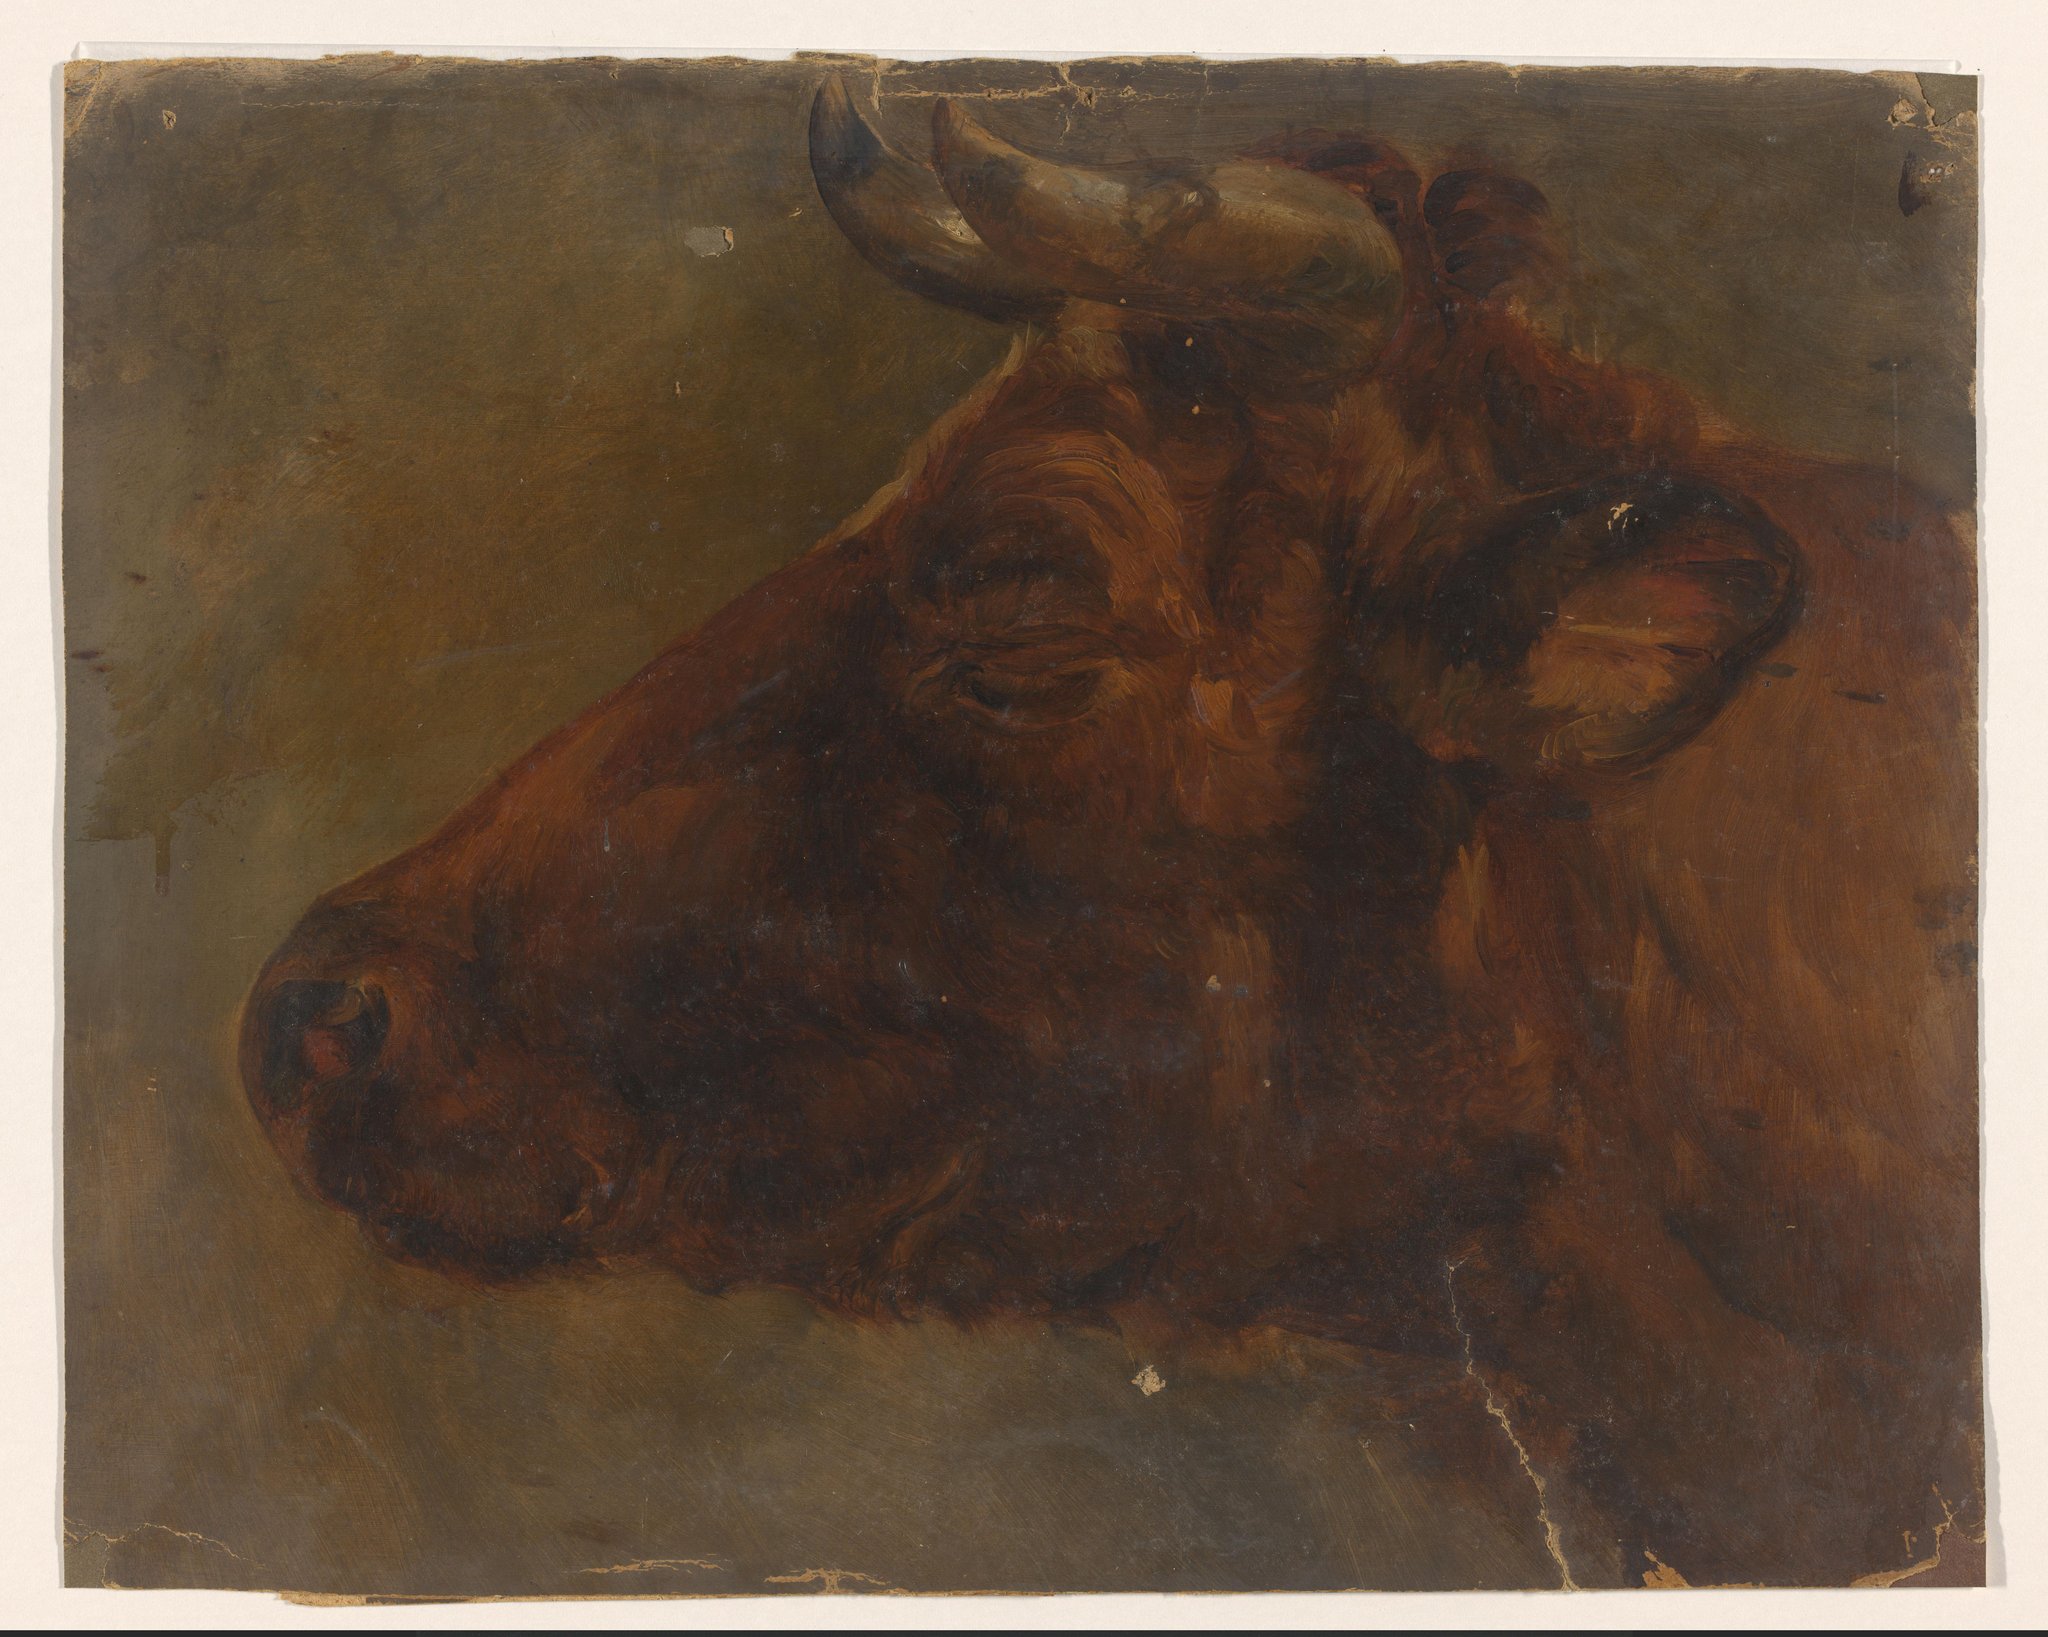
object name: drawing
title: Studie van een koeienkop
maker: jan bedijs tom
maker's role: draughtsman, painter, print maker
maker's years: 1813-1894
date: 1823-1894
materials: cardboard, oil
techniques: brush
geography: the hague